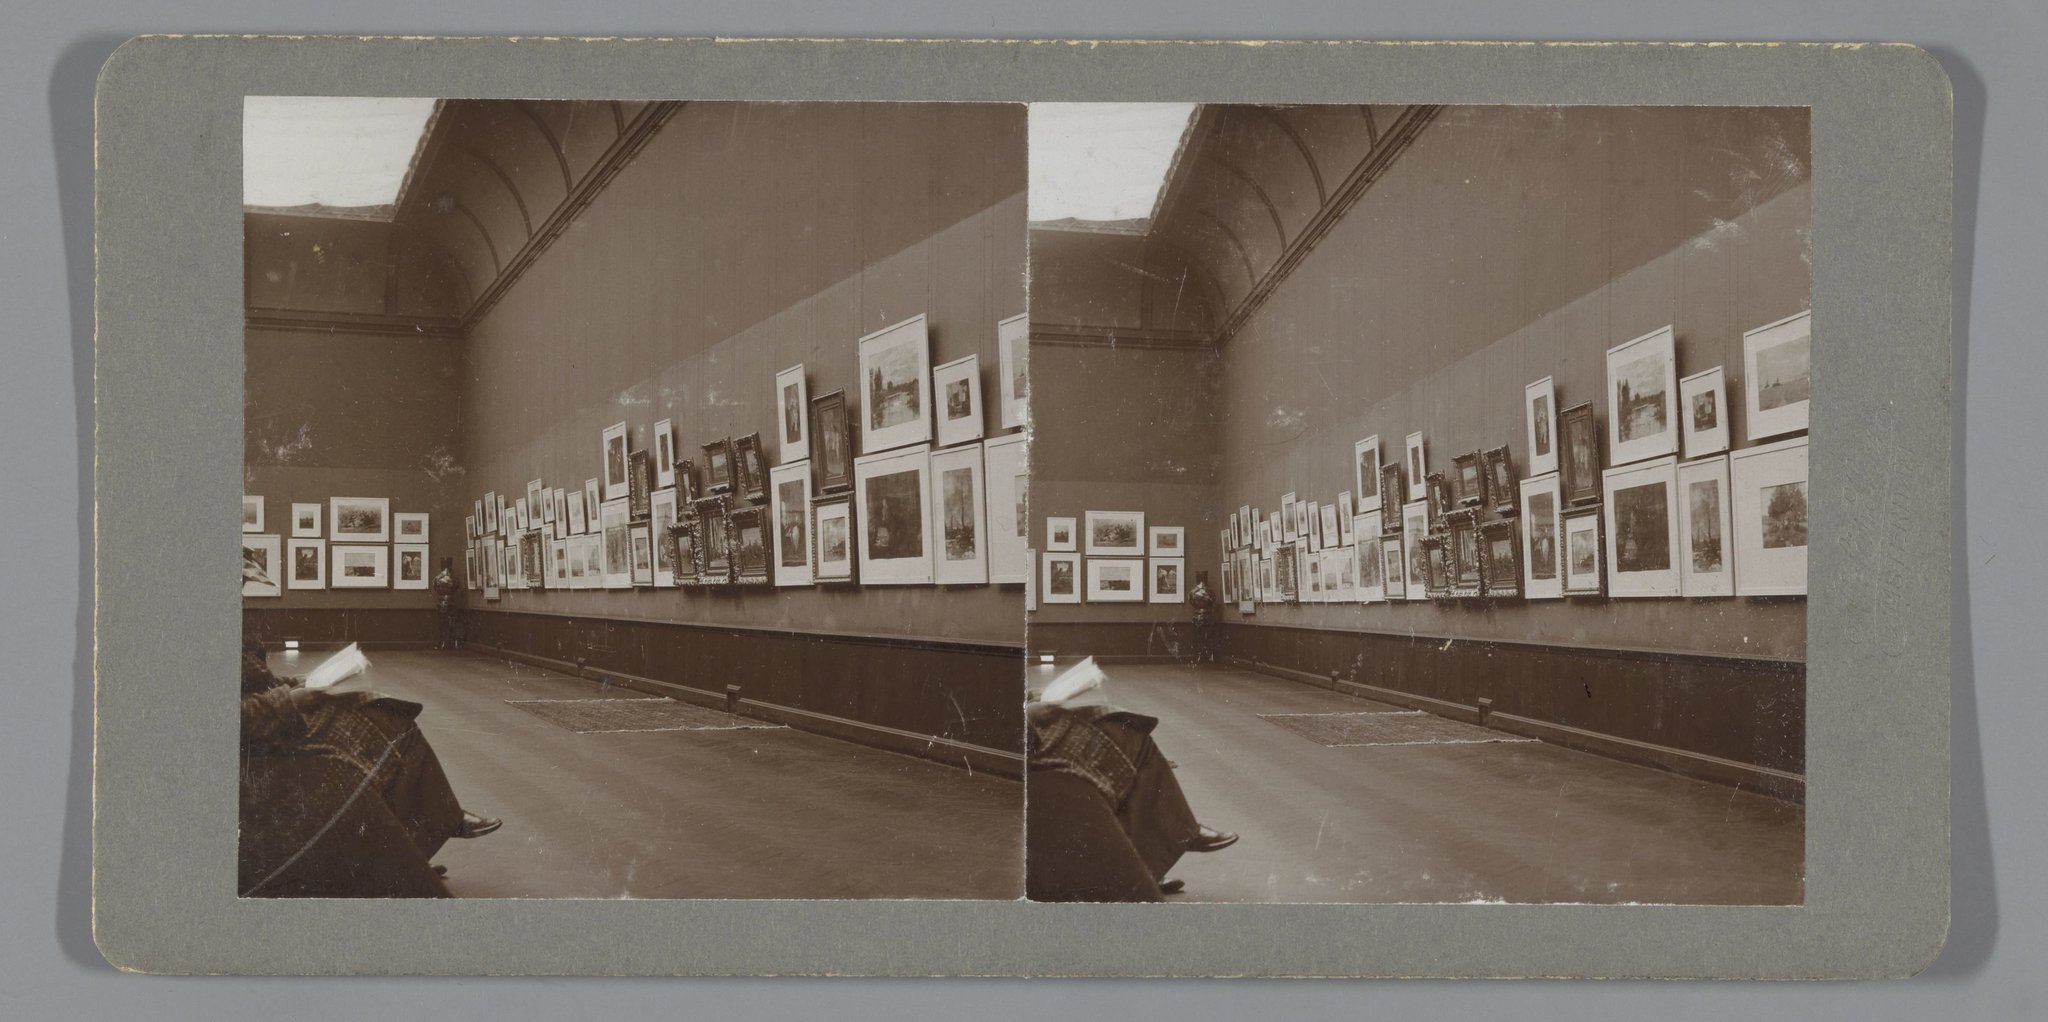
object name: stereograph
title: Gezicht in een zaal van het Stedelijk Museum, Amsterdam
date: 1902-1920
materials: paper, cardboard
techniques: gelatin silver print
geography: amsterdam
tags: collection, exhibition, show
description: Tijdens een tentoonstelling van de Vereeniging tot het Vormen van eene openbare verzameling van Hedendaagsche Kunst (VVHK, ook wel de 'vereeniging met de lange naam' genoemd).